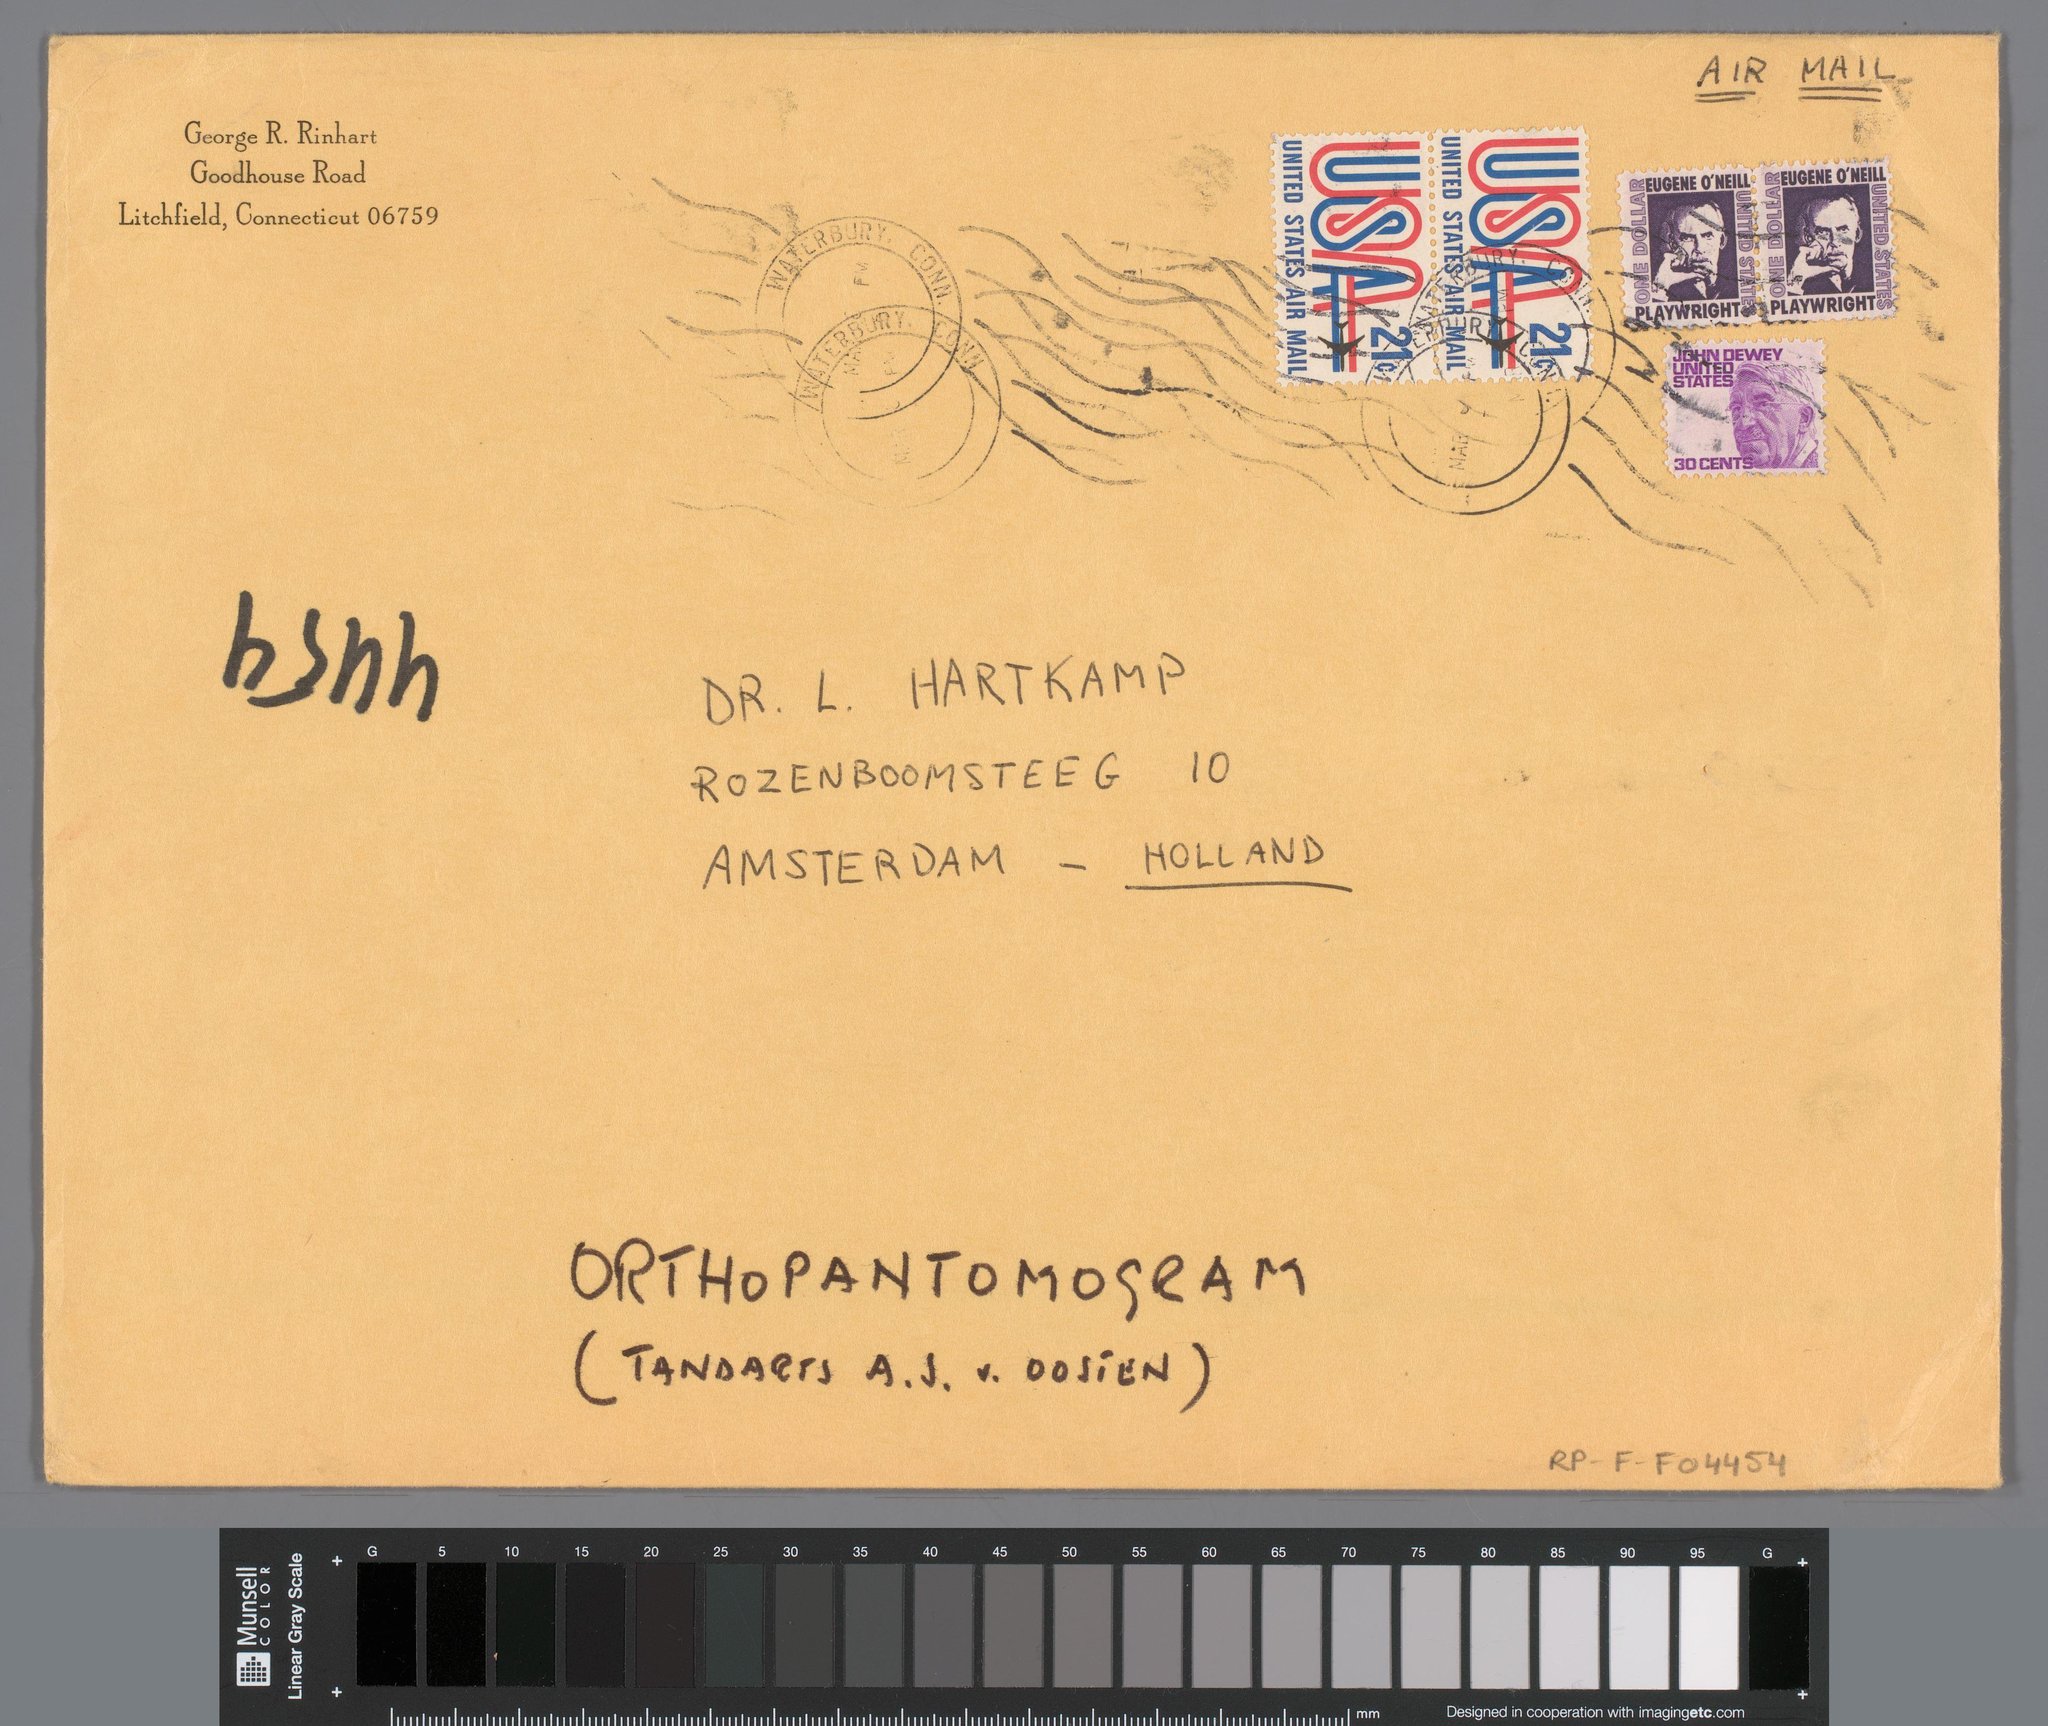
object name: x ray photograph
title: Orthopantomogram van mevr. Dannile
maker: Anonymous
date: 1974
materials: paper, plastic, film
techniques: gelatin silver negative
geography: united states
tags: jaw (human) - aa - female human figure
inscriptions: inscription: ‘SIEMENS - SPECIAL - RUCKFOLLE F-89 V292’, address: ‘A. S. van Oosten, tandarts/ Wijkgebouw/ Edam/ Telefoon 02993 - 1484/ Behandeling volgens afspraak.’, address: ‘George R. Rinhart/ Goodhouse Road/ Litchfield, Connecticut 06759’, inscription: ‘Mev Dannile [?] 28/5/74’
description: Orthopantomogram met onderzoeksdatum 28 mei 1974, de opname zit in een gele envelop met daarop de naam van tandarts A.S. van Oosten.